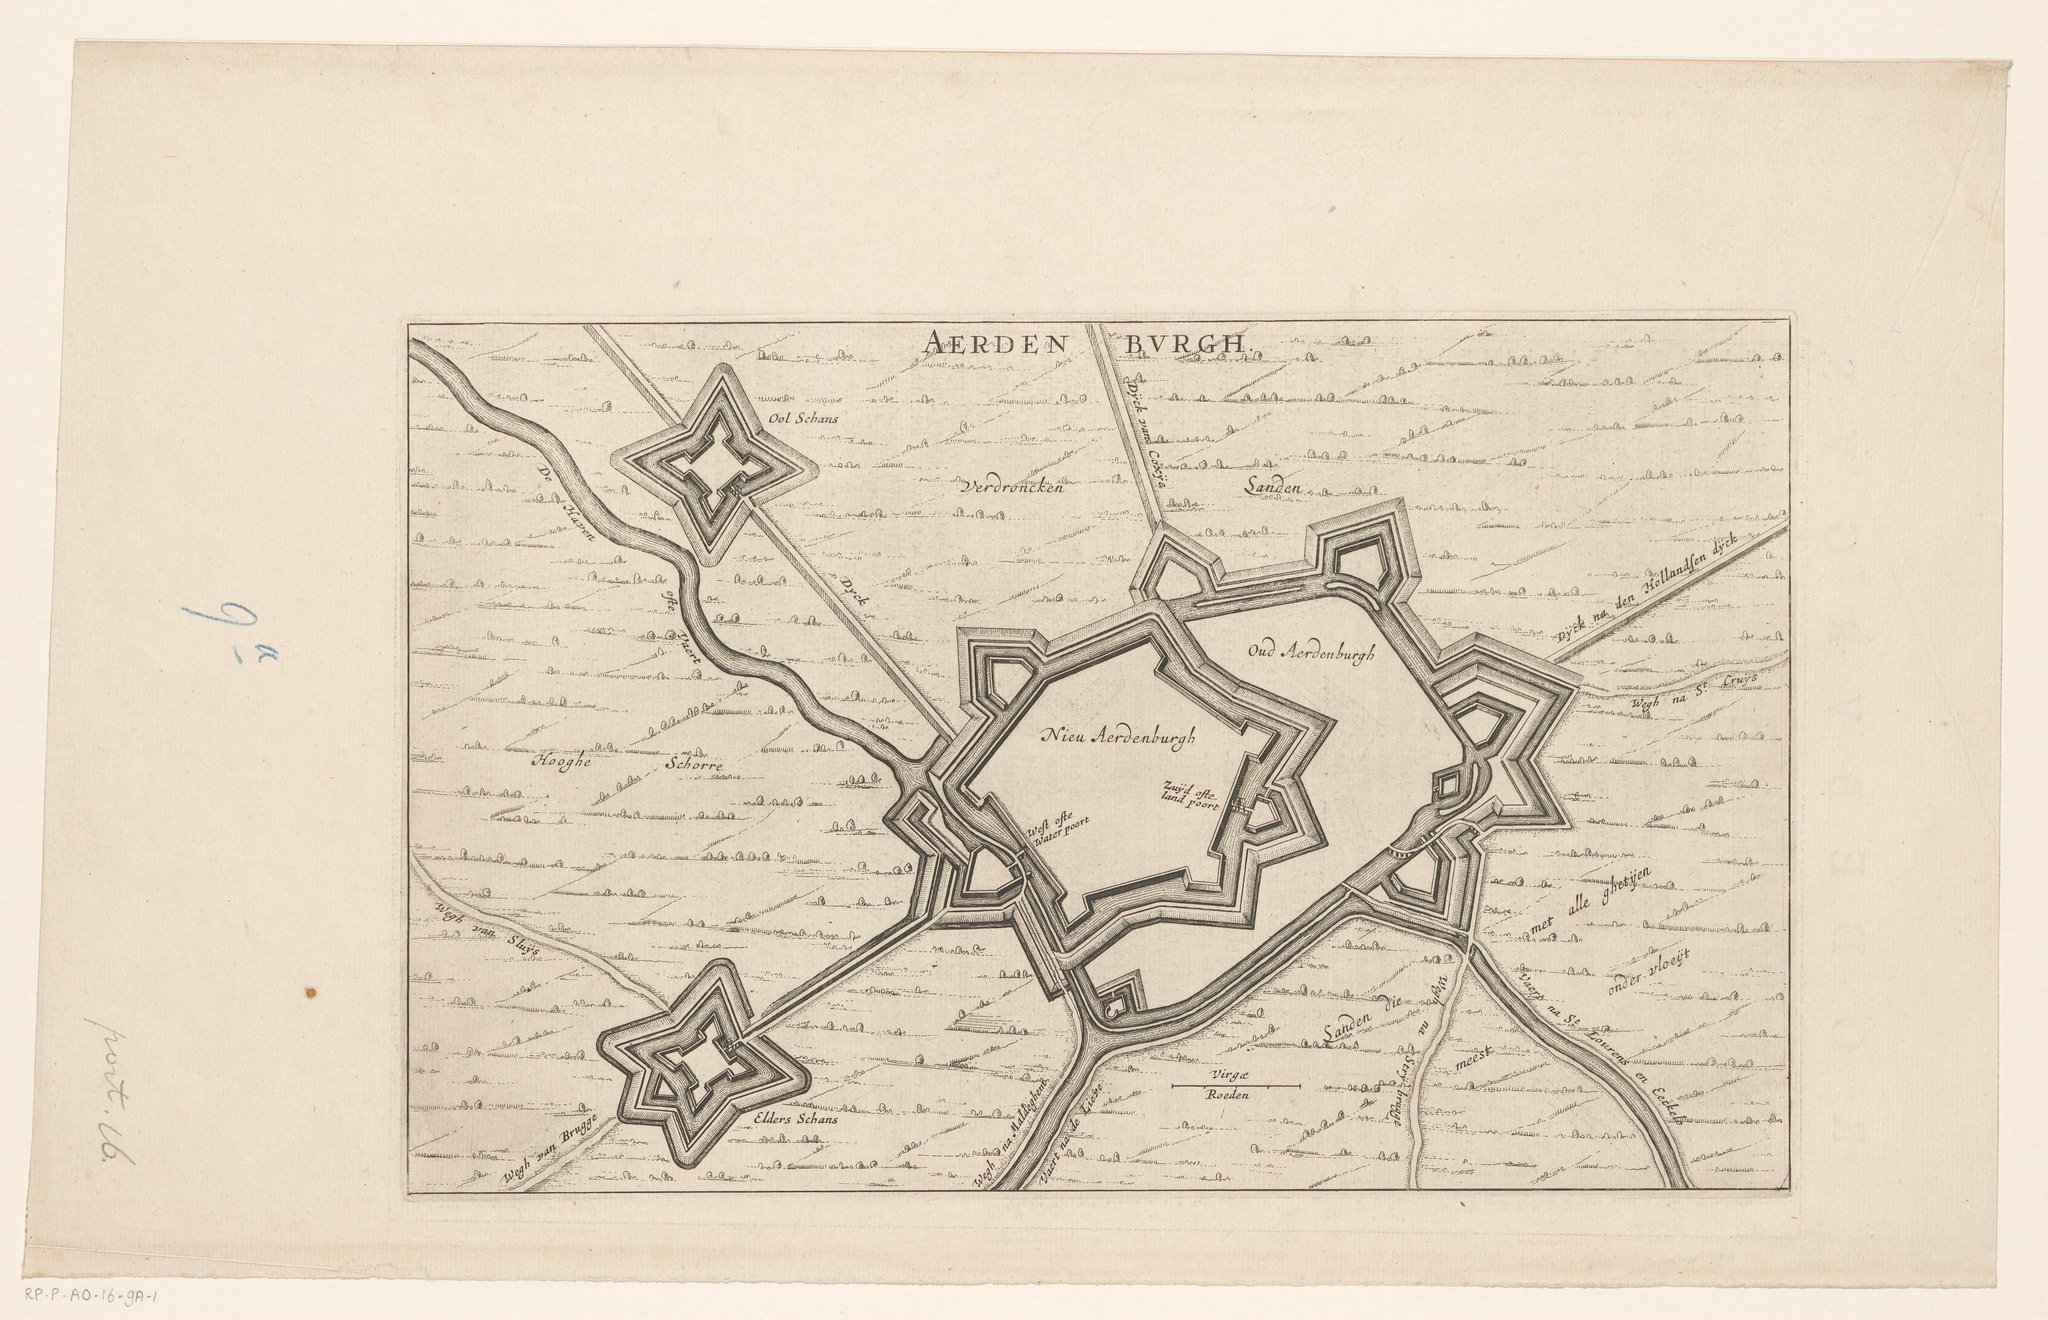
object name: area plan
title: Aerdenburgh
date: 1652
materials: paper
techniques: engraving, etching, letterpress printing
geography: amsterdam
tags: fortified city, maps of cities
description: Prent gebruikt in: Blaeu, Johannes Willemszoon. Novum ac magnum theatrum urbium Belgicae (...). 2 delen. 3e druk. Amsterdam: Johannes Willemszoon Blaeu, 1652, dl. 1.